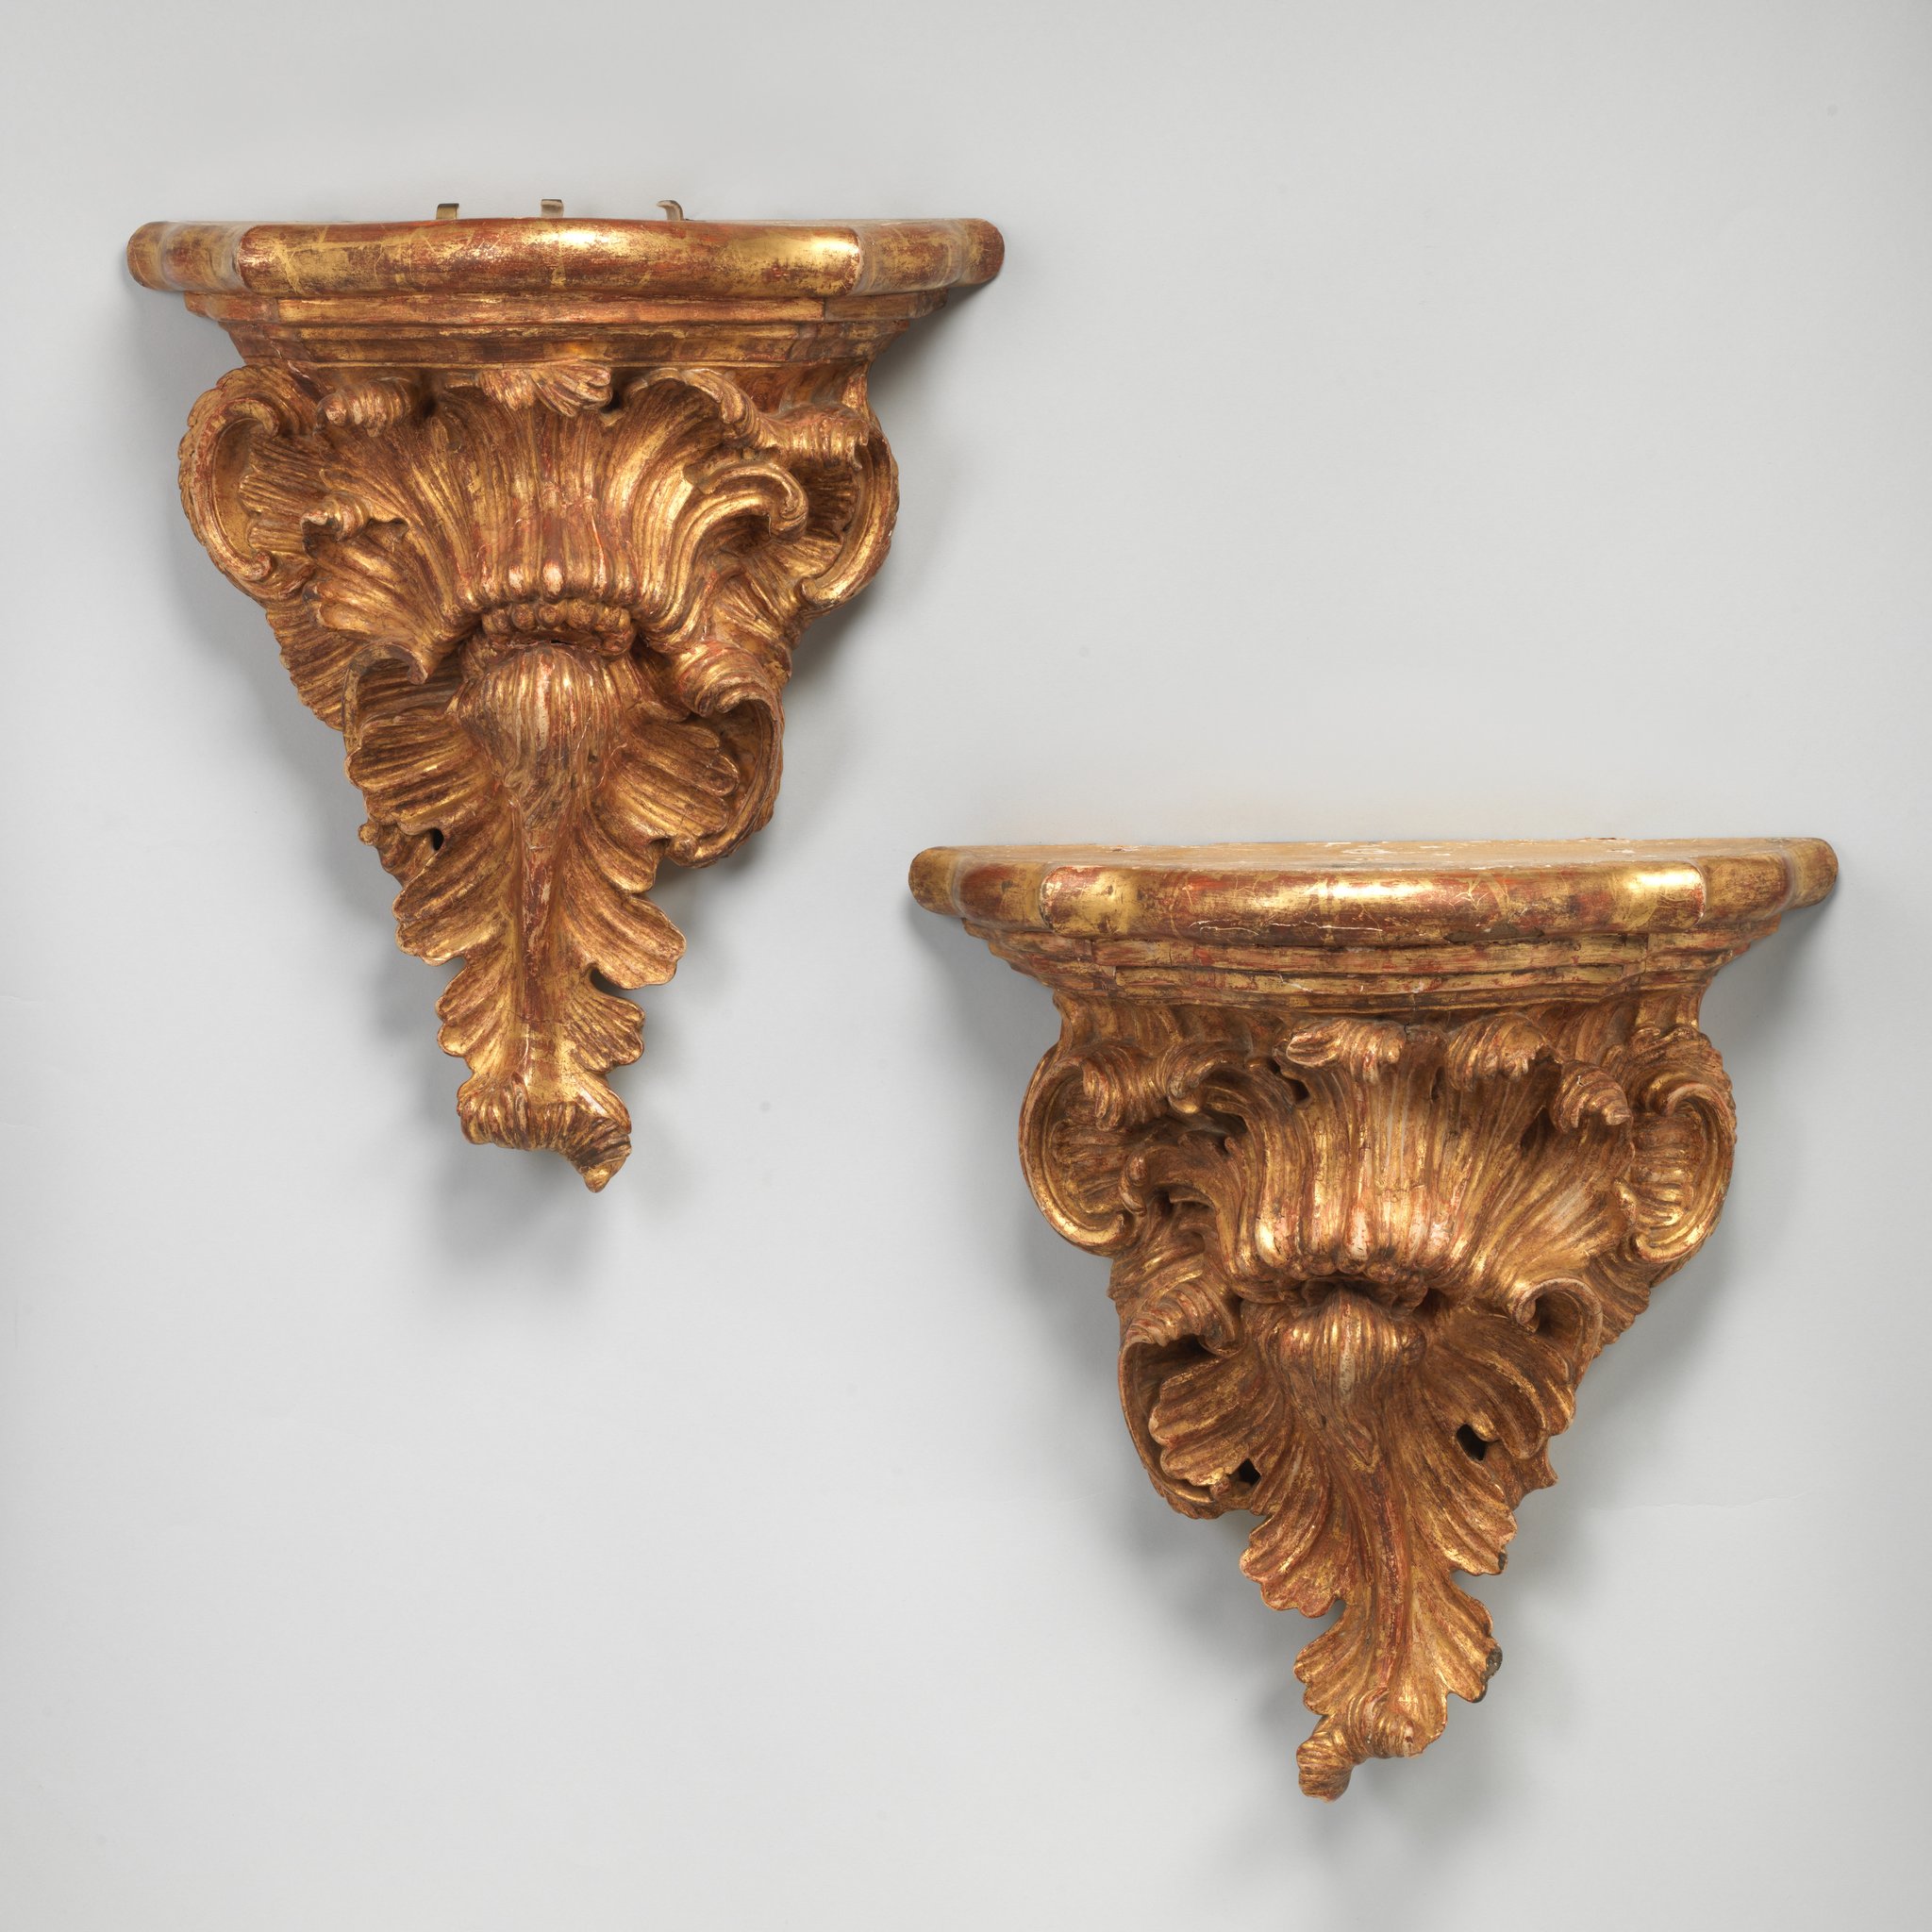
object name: wall bracket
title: Pair of wall brackets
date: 1750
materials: wood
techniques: carving, gilding